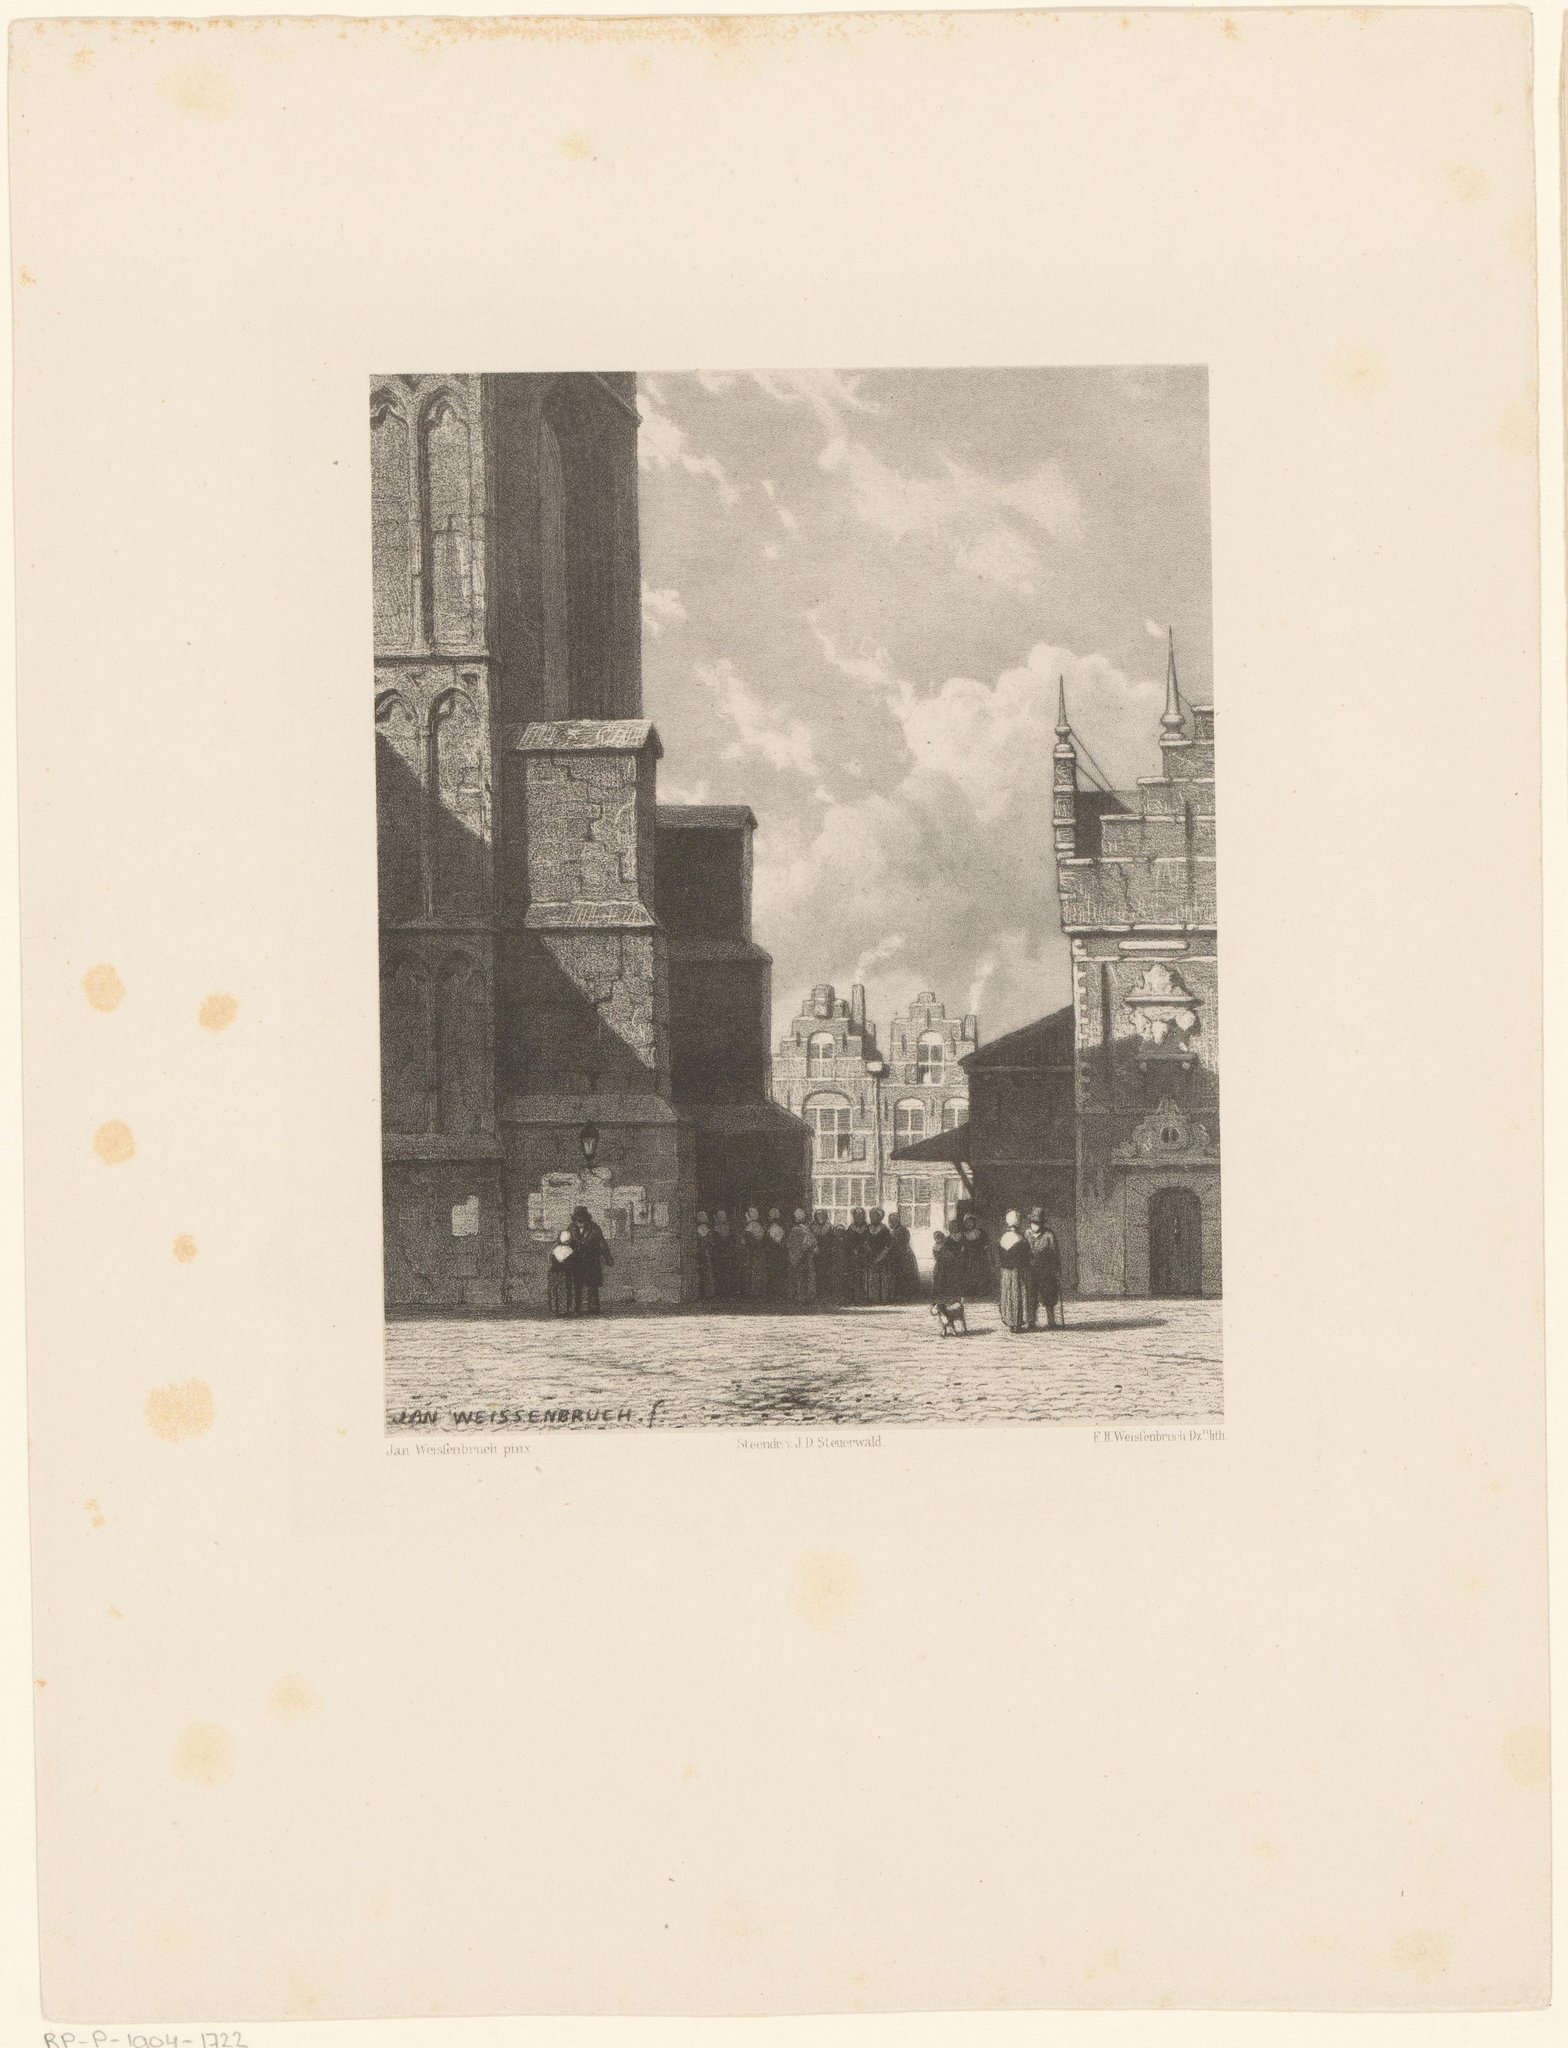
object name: print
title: Sint-Bavokerk en de Vleeshal te Haarlem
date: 1838-1863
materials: paper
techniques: lithograph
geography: the hague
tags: city-view in general; 'veduta'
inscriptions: collector's mark: Lugt 2228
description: Gezicht te Haarlem met links een deel van de Sint-Bavokerk en rechts een deel van de Vleeshal. Voor het kerkportaal staat een groep mensen.